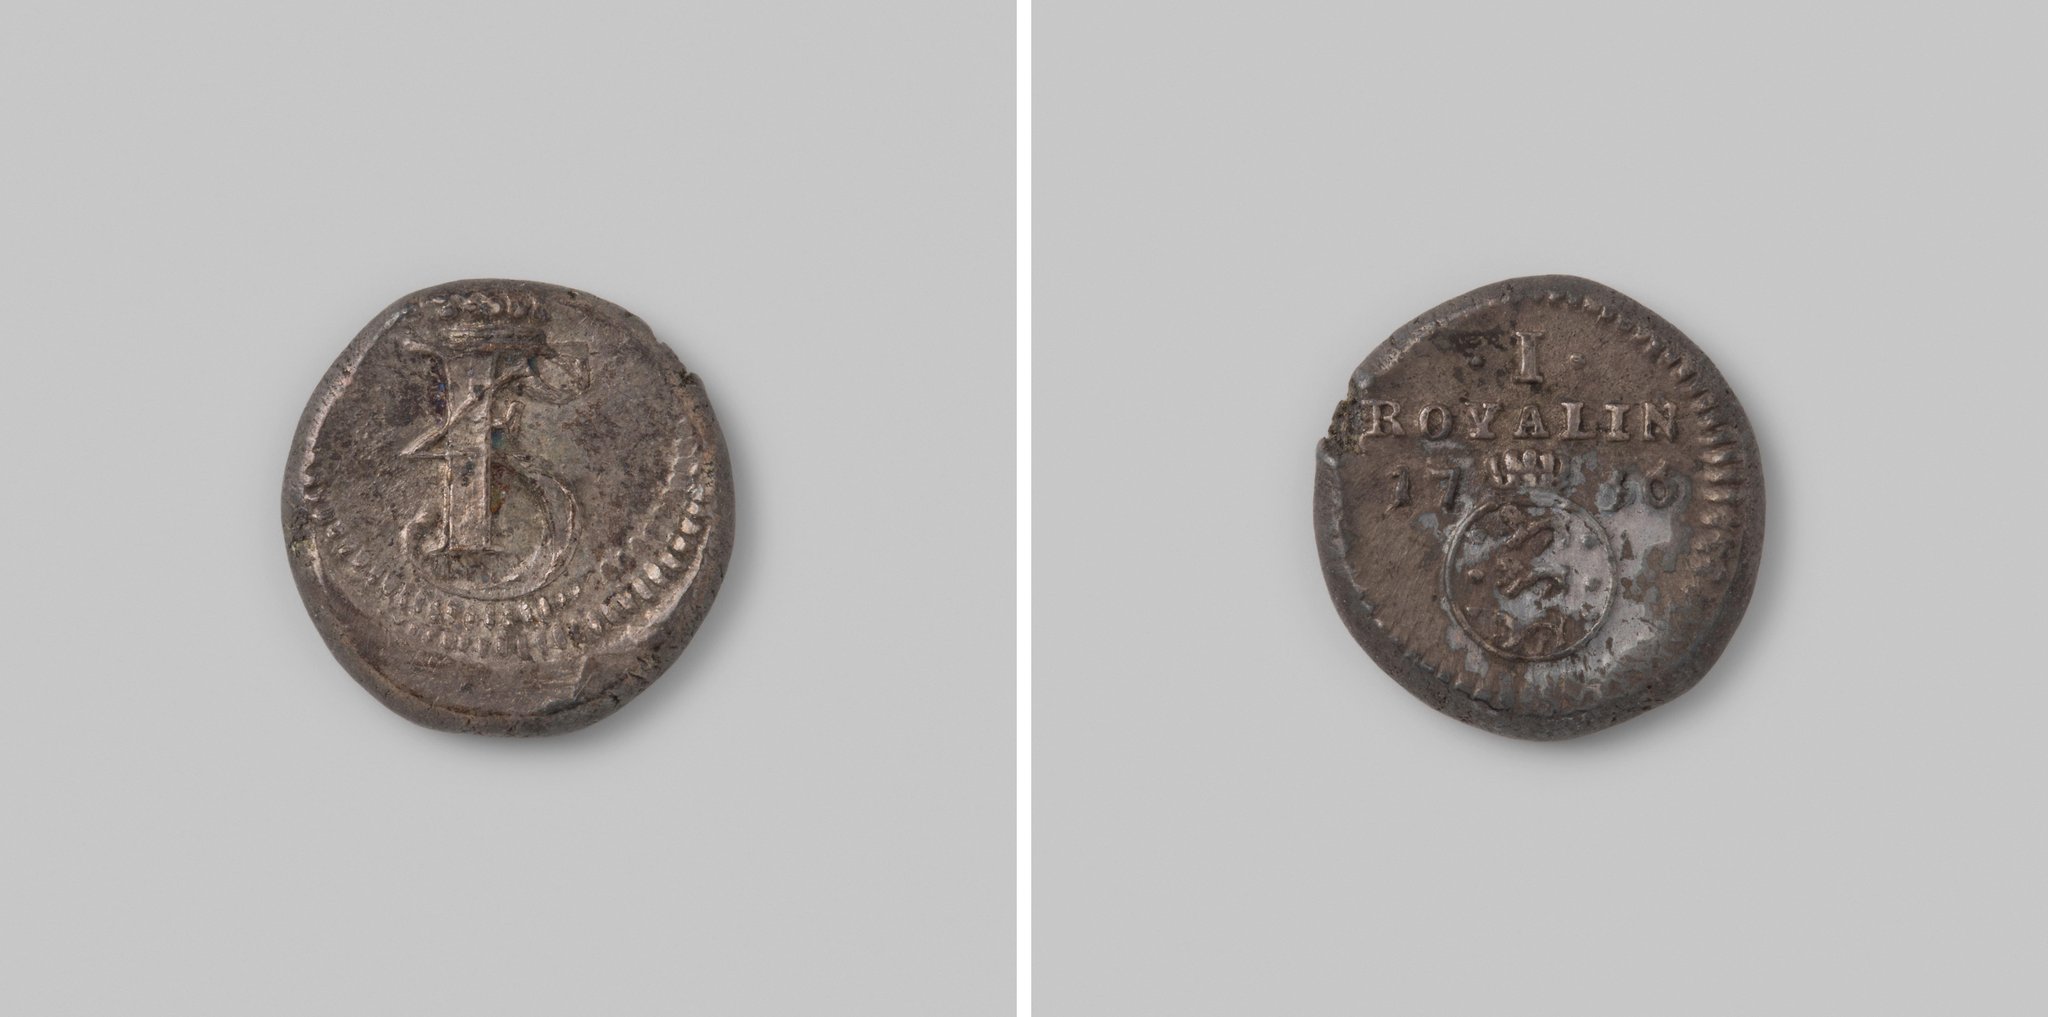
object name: coin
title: Tranquebar, Deens-India, Deense Aziatische Compagnie (DAC) op naam van koning Frederik V, royalin, 1756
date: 1756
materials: silver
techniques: striking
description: Zilveren munt. Voorzijde: gekroond monogram van de koning. Keerzijde: waarde-aanduiding: 1 royalin in twee regels. Daaronder tussen jaartal gekroond ovaal Deens wapenschild. Gladde rand.